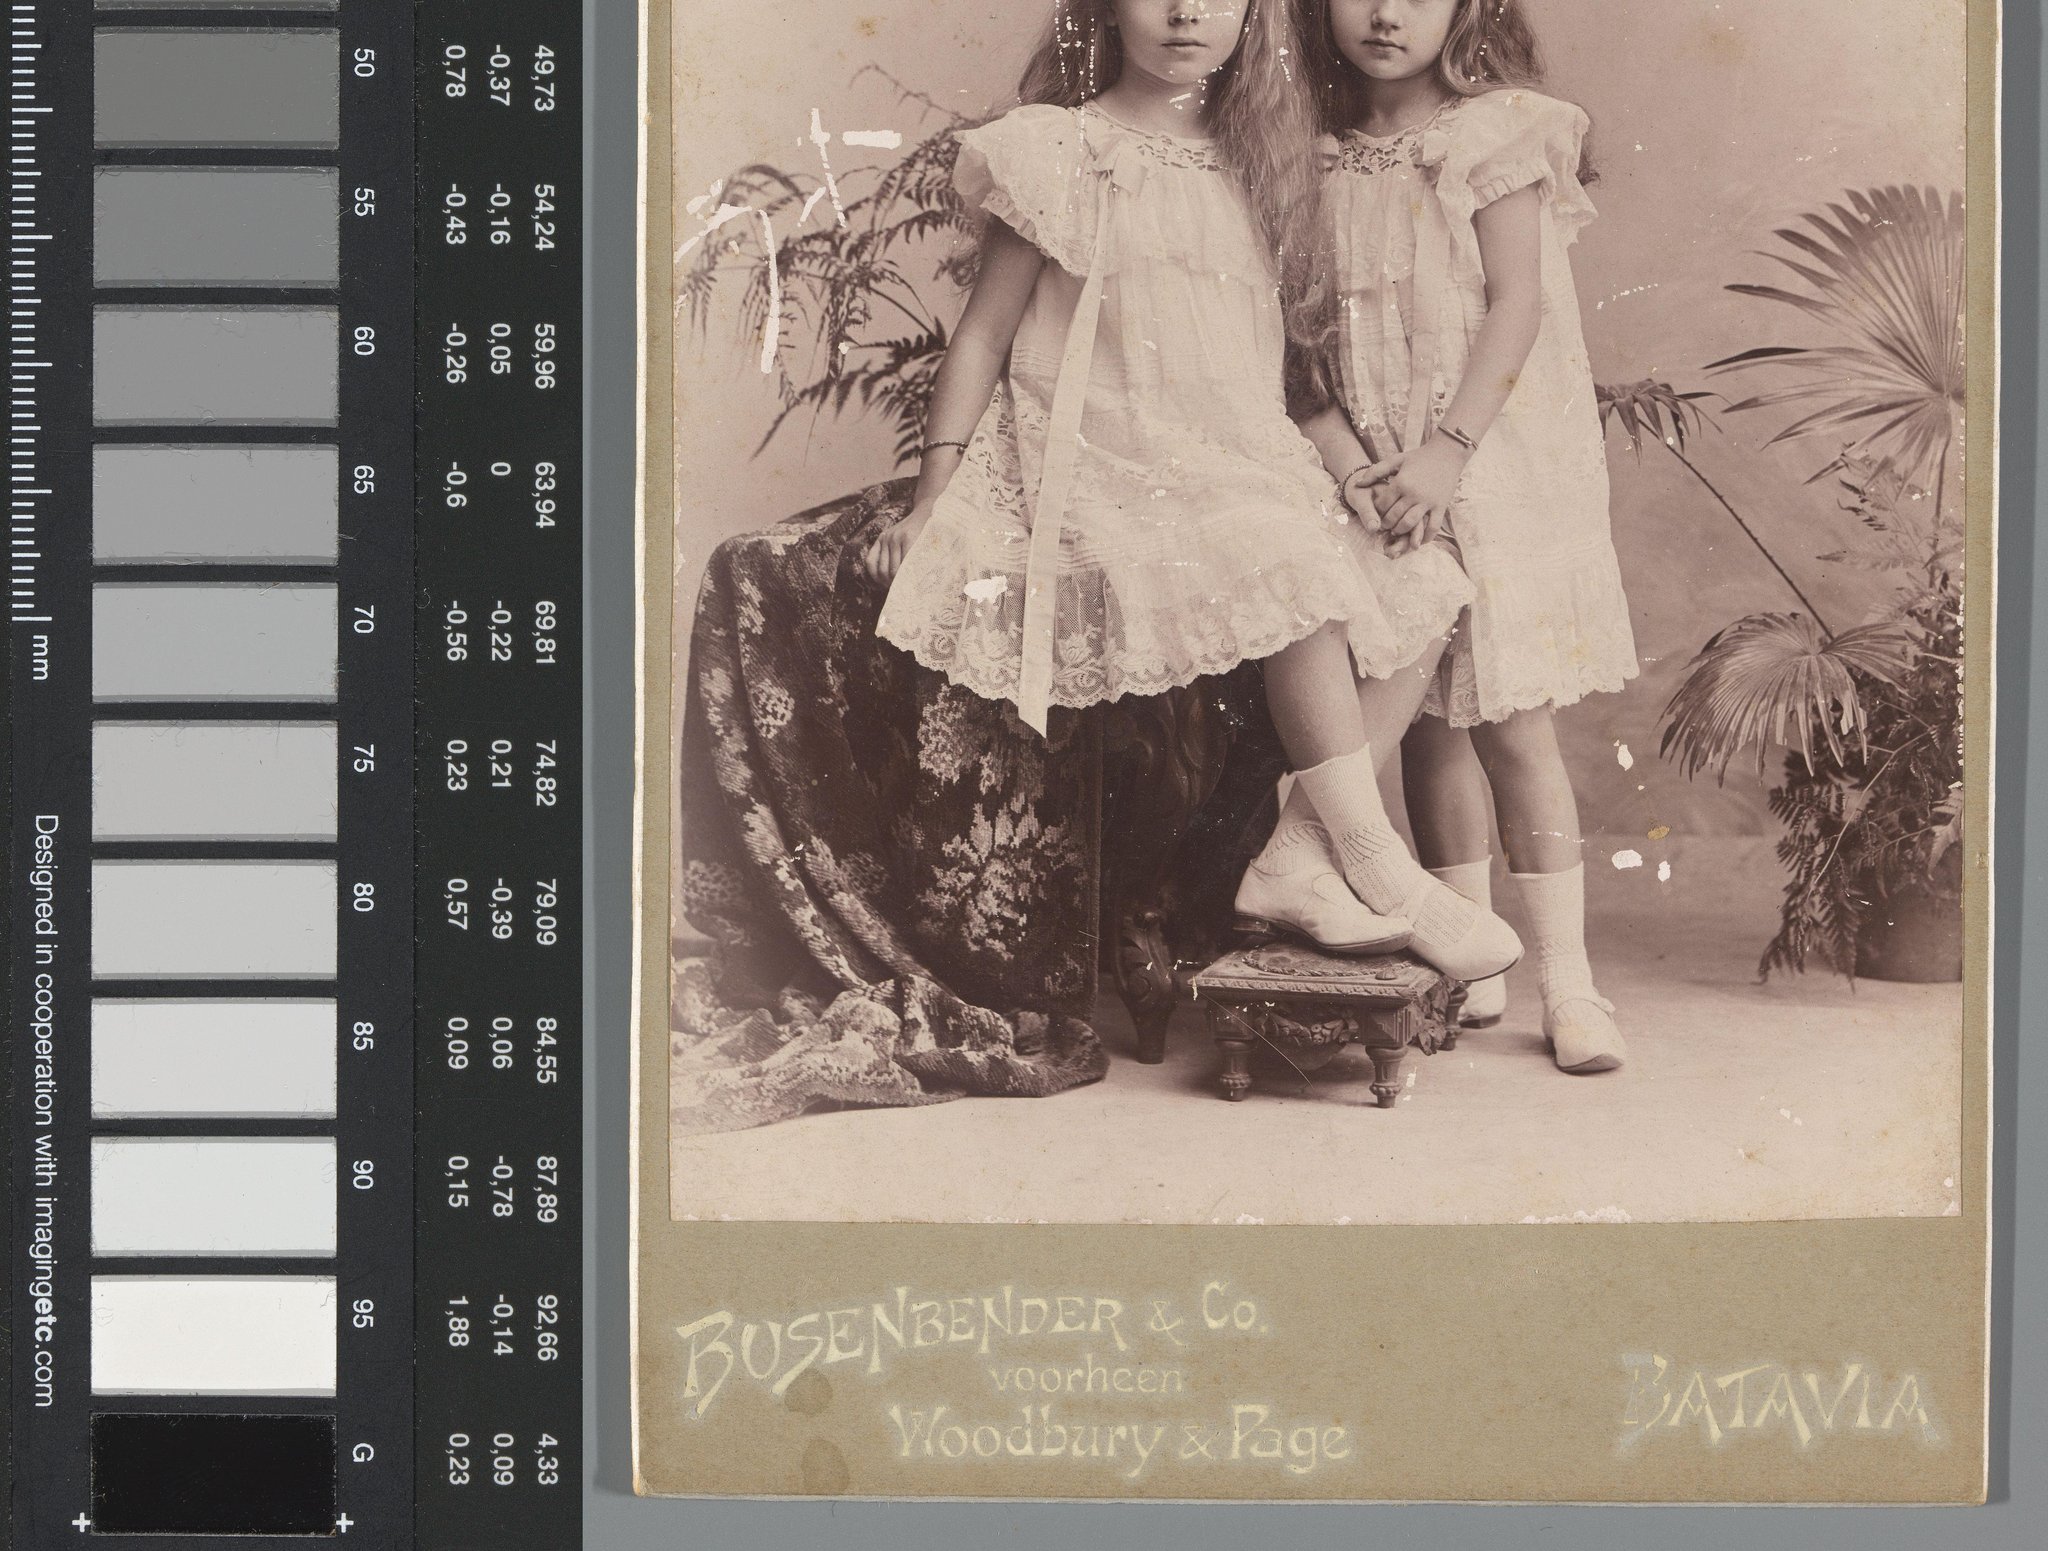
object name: cabinet photograph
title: Studioportret van twee dochters van Emilie van den Berg en Piet Onnen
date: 1900-1910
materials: cardboard, photographic support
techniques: albumen print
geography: batavia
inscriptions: name: ‘Photographie / Busenbender & Co / voorheen/ Woodbury & Page / BATAVIA’, name: ‘Busenbender & Co / voorheen / Woodbury & Page / BATAVIA’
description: Twee meisjes met elk een strik in het haar tegen een achtergrond met kamerplanten.